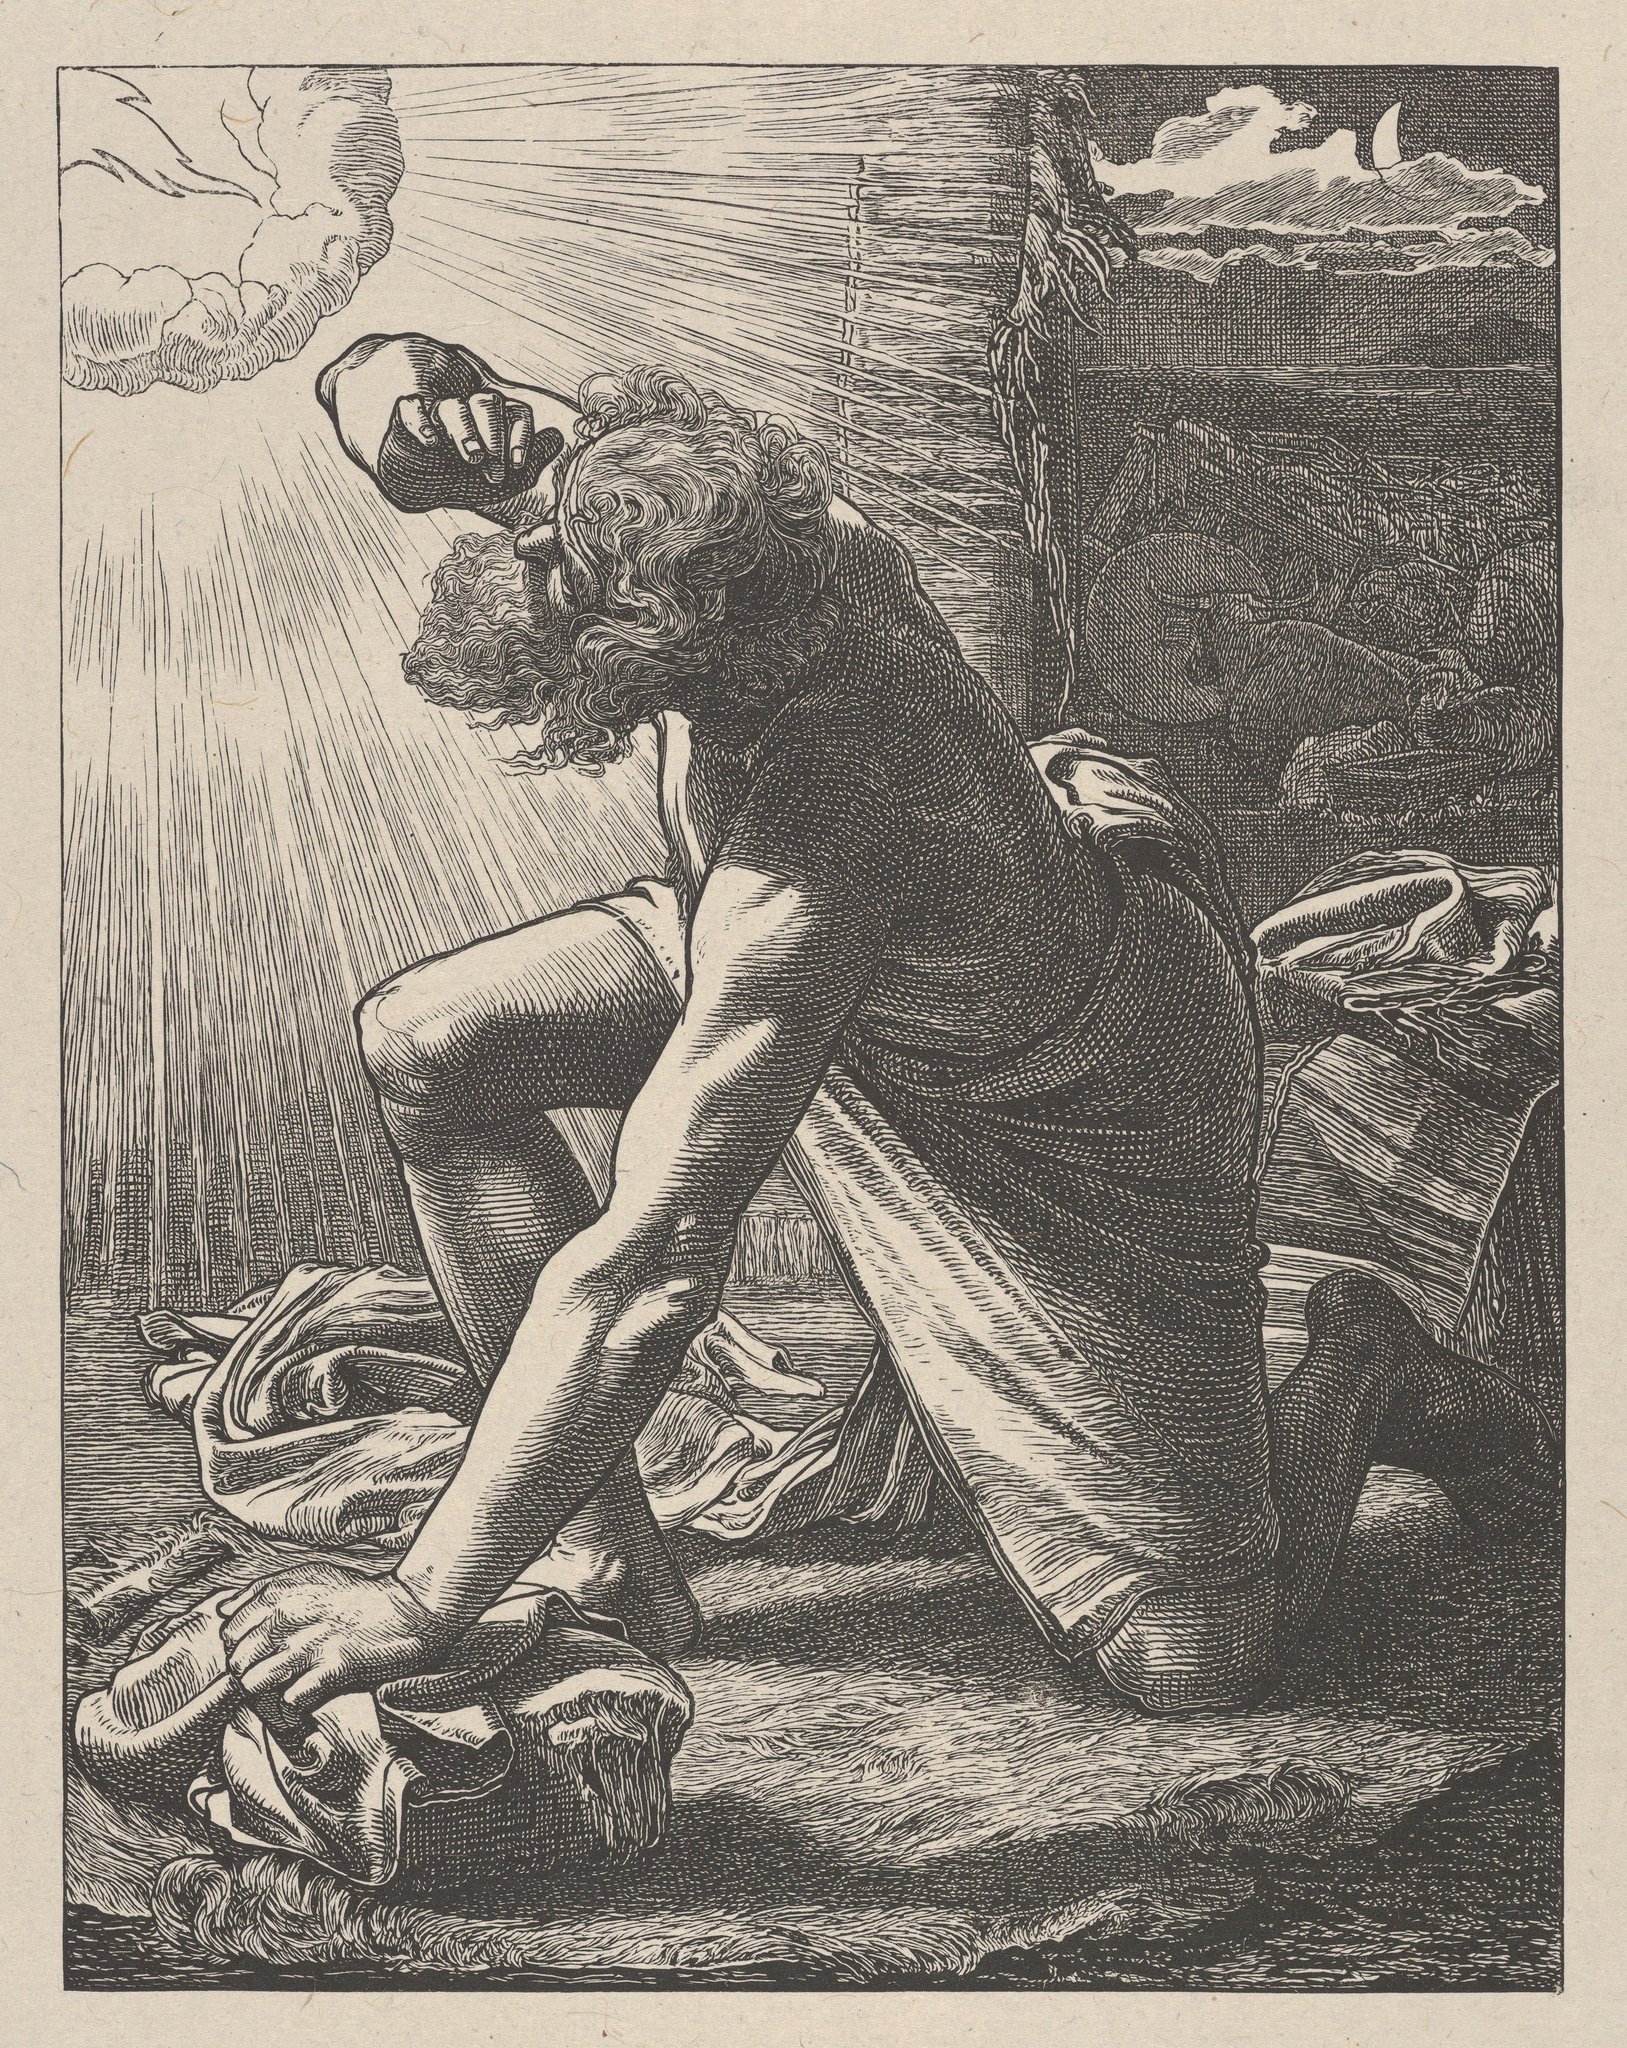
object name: print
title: Jacob Hears the Voice of the Lord, from "Dalziels' Bible Gallery"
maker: frederick augustus sandys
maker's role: artist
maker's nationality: british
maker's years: 1829-1904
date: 1865-1881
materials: paper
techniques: engraving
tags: men